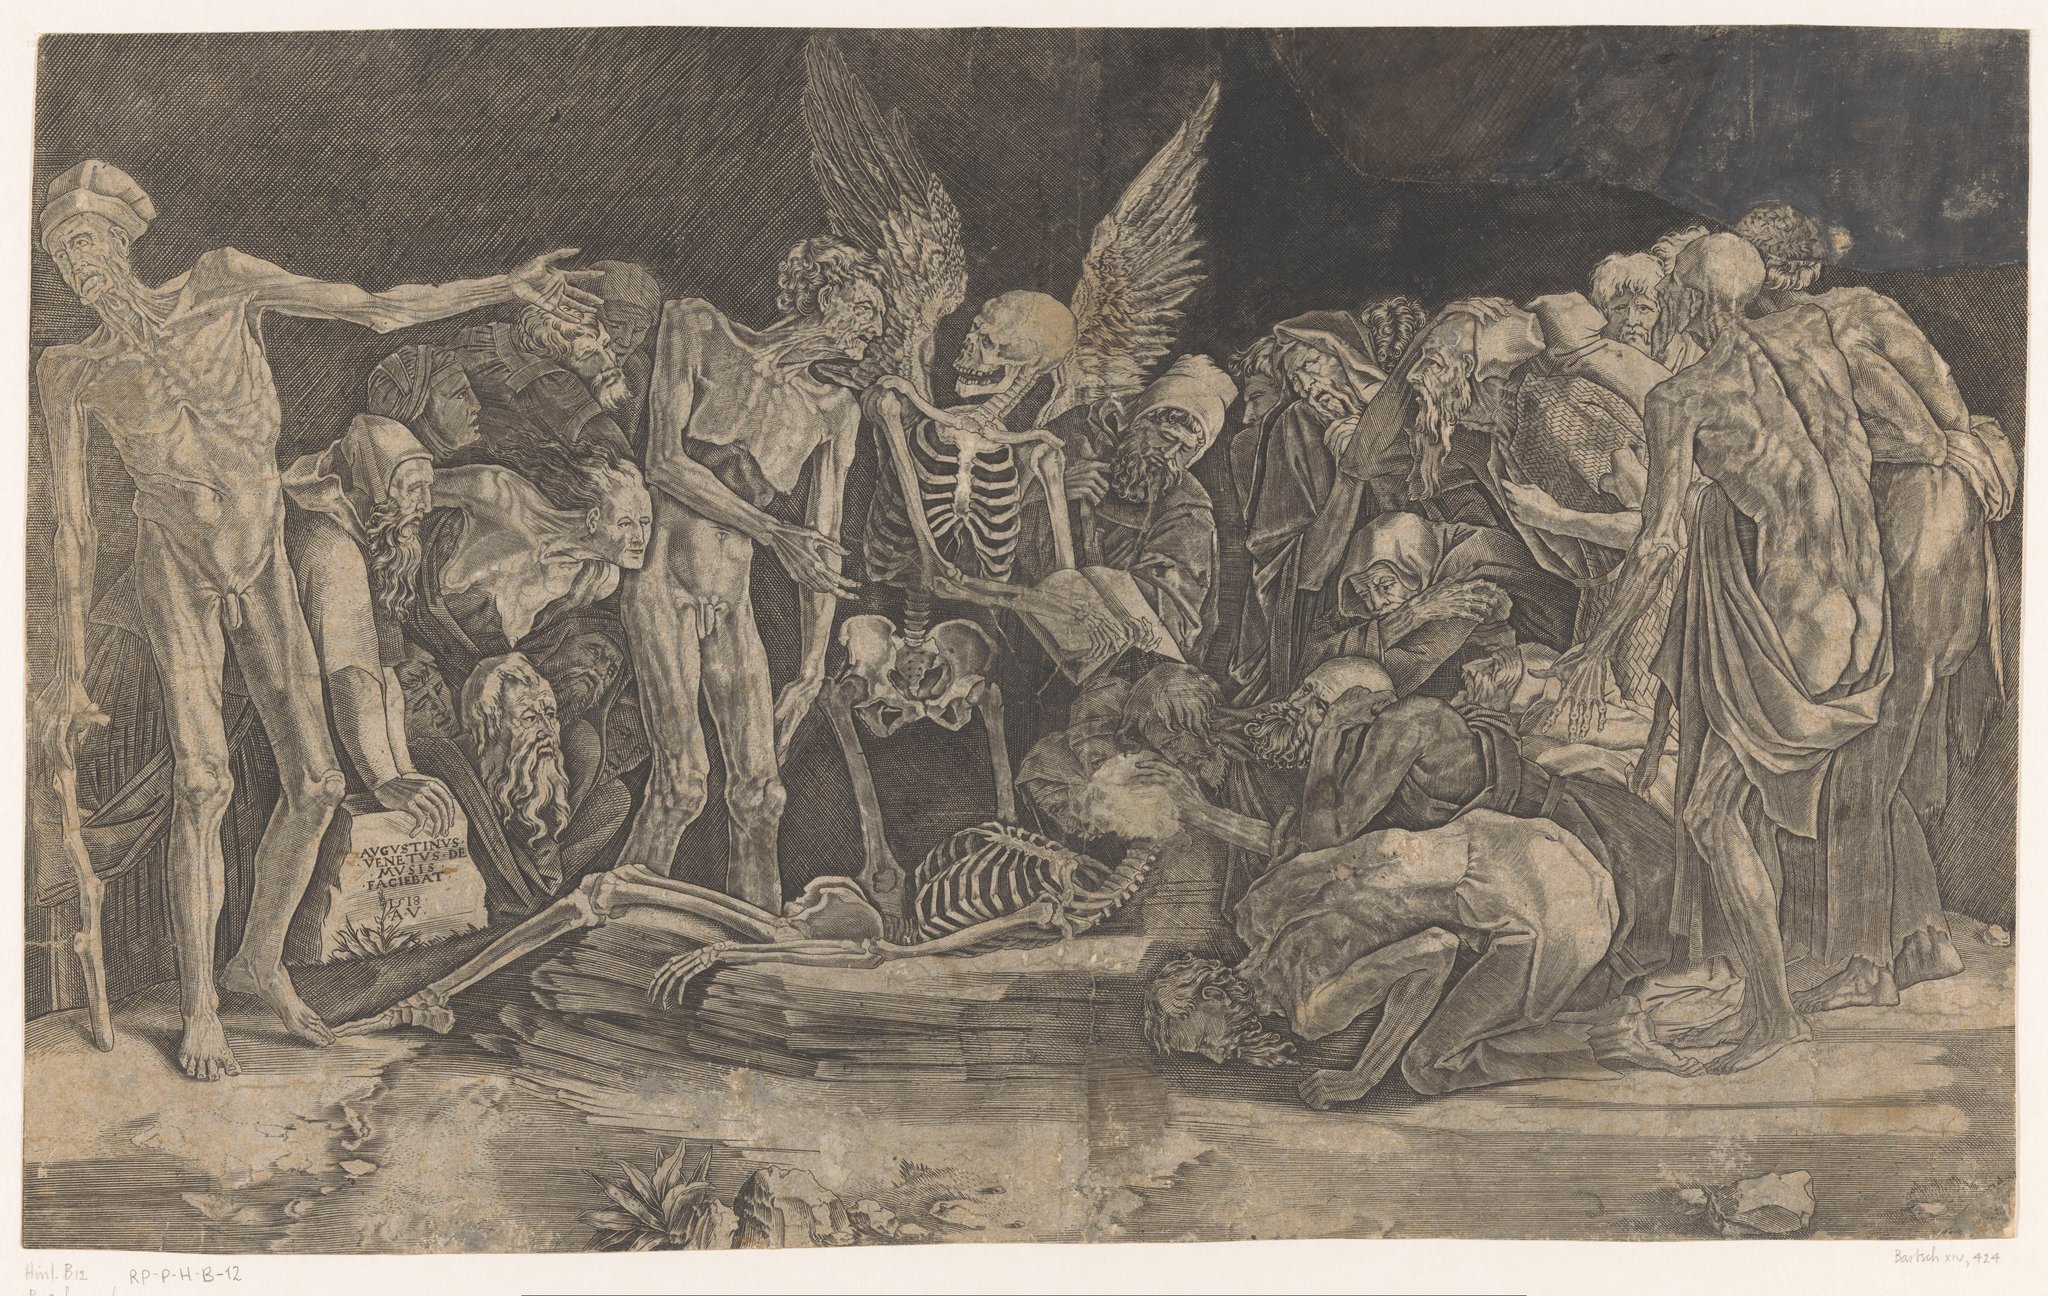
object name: print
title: Skeletten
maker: agostino veneziano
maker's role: draughtsman, painter, print maker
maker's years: 1490-1536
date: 1518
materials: ink, paper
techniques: engraving, etching, pen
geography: italy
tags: hunger, death as skeleton, (human) skeleton (+ lying), (human) skeleton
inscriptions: collector's mark: Lugt 11, collector's mark: Lugt 10, collector's mark: ‘Hinloopen’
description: Beschadiging midden onder, aangevuld met een gearceerd gedeelte van een andere prent. Rechtsboven is een groter missend gedeelte van de prent aangevuld en ingevuld met pen in zwarte inkt. Het missende gedeelte van het hoofd van de meest rechter figuur is aangevuld met een hoofd met lauwerkrans uit een andere prent.